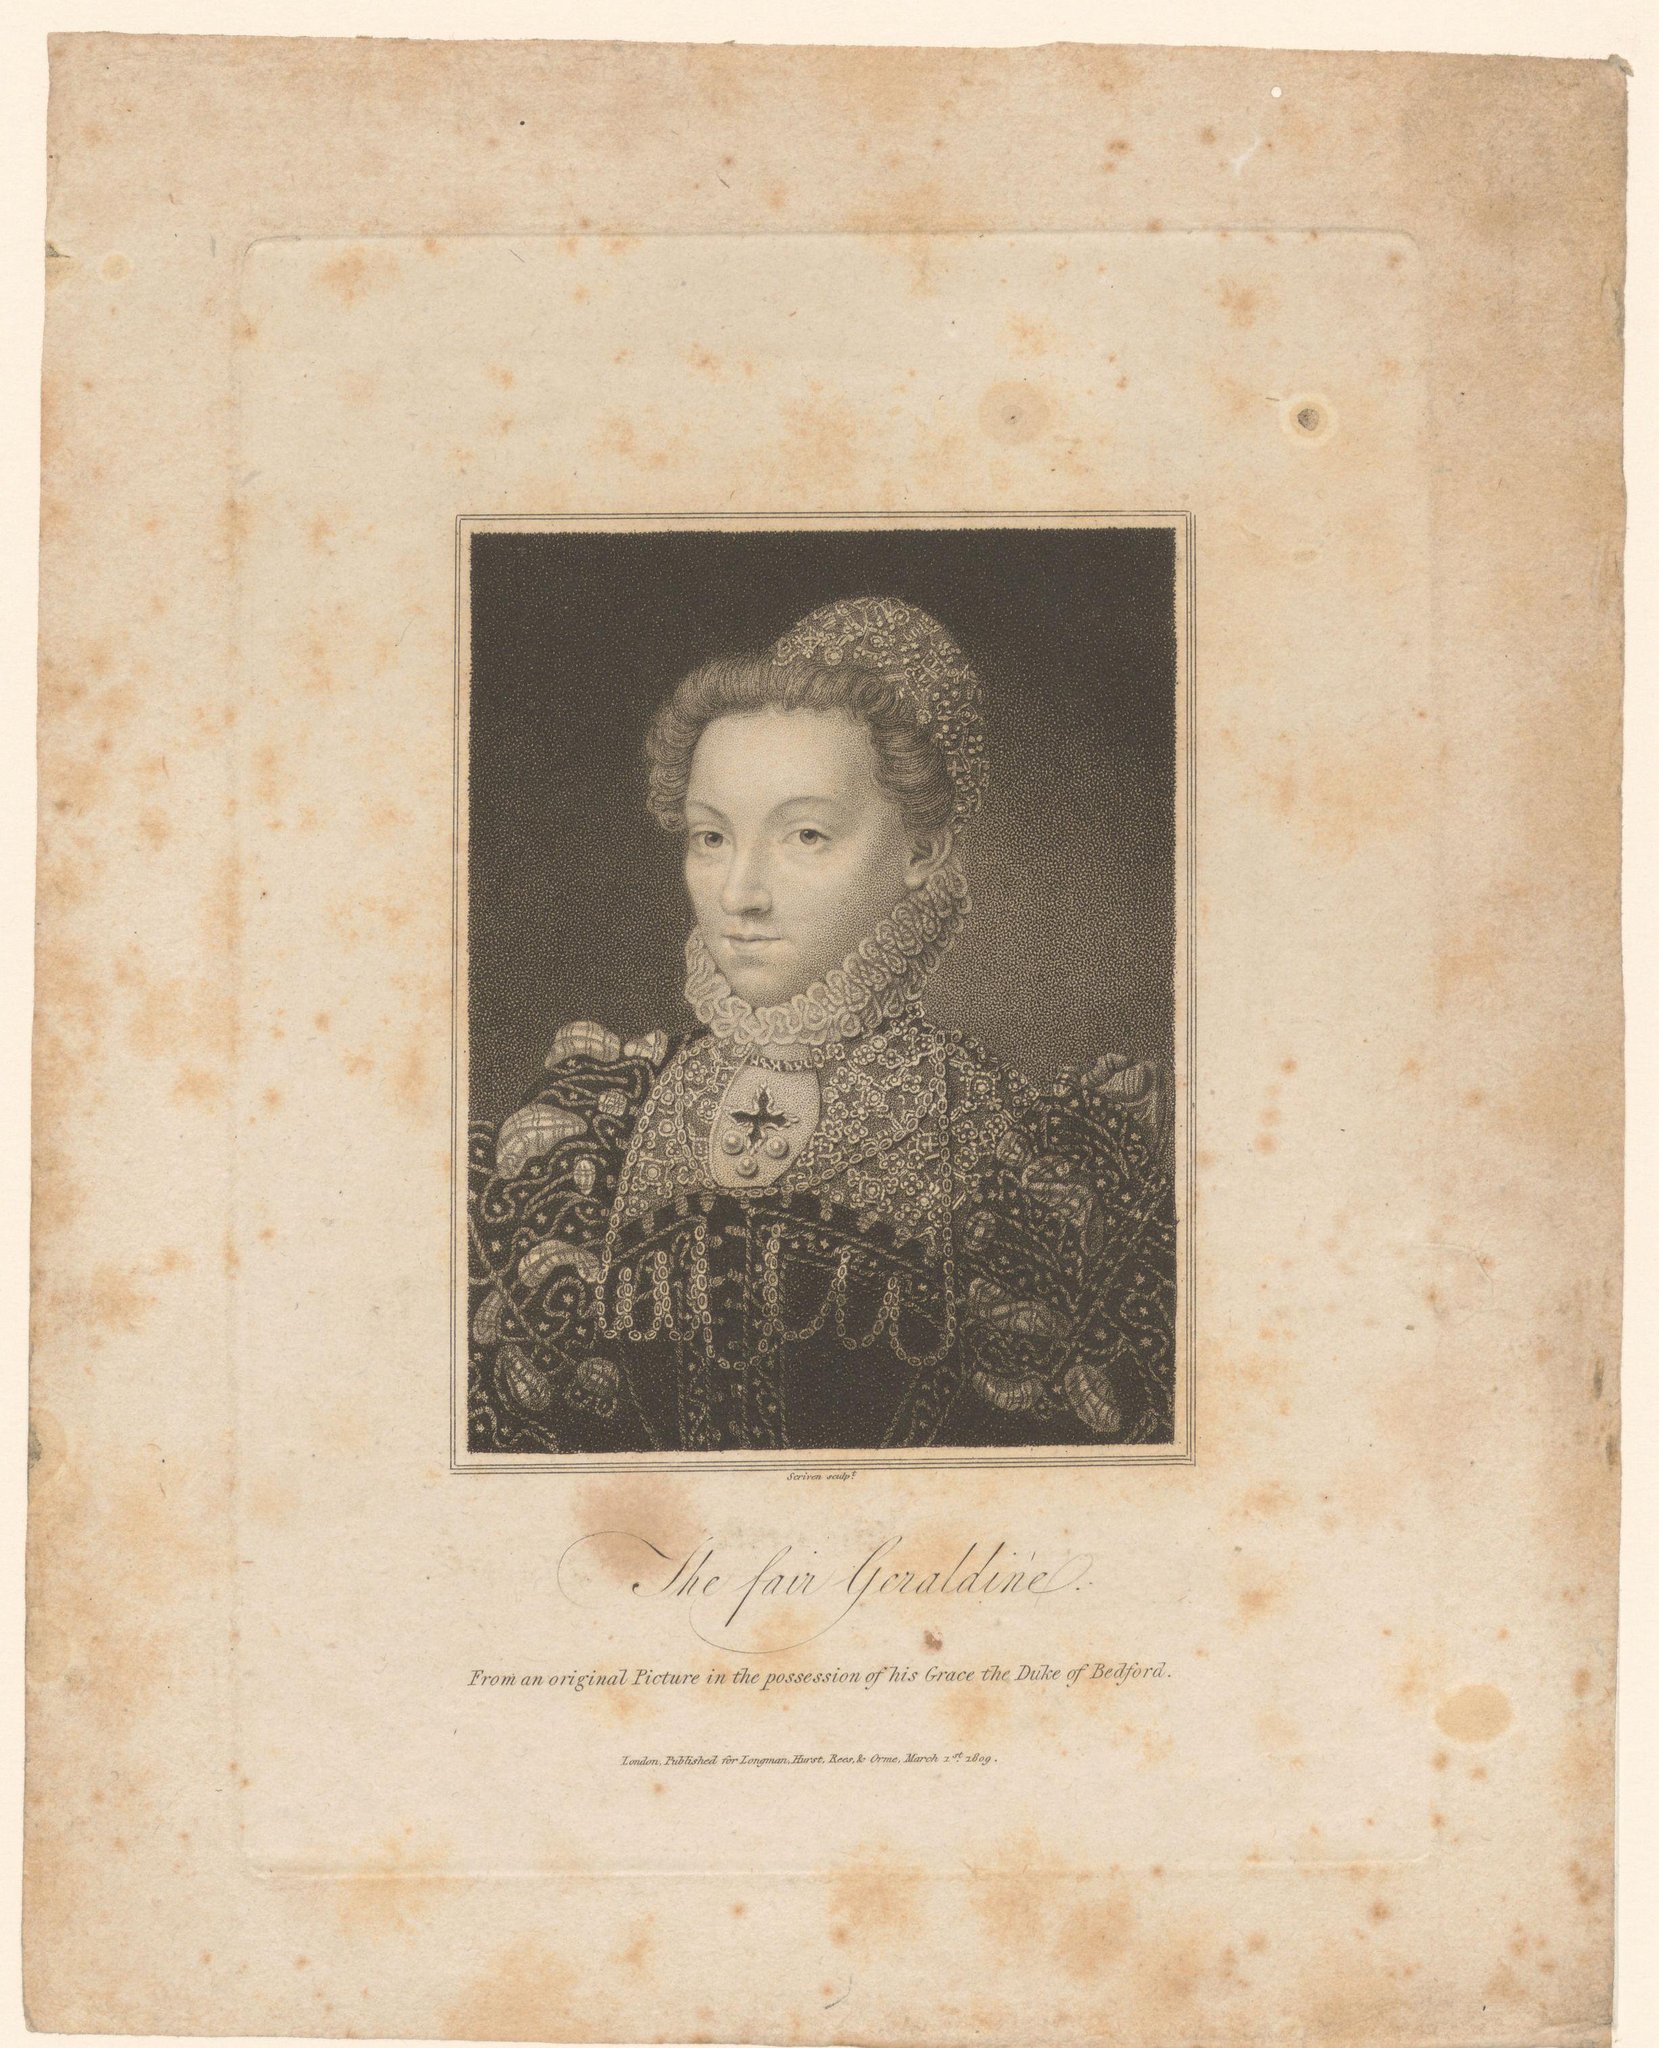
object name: print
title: Portret van Elizabeth Clinton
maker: edward scriven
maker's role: print maker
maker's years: 1775-1841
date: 1809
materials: paper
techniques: etching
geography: london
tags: historical persons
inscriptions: collector's mark: Lugt 2228